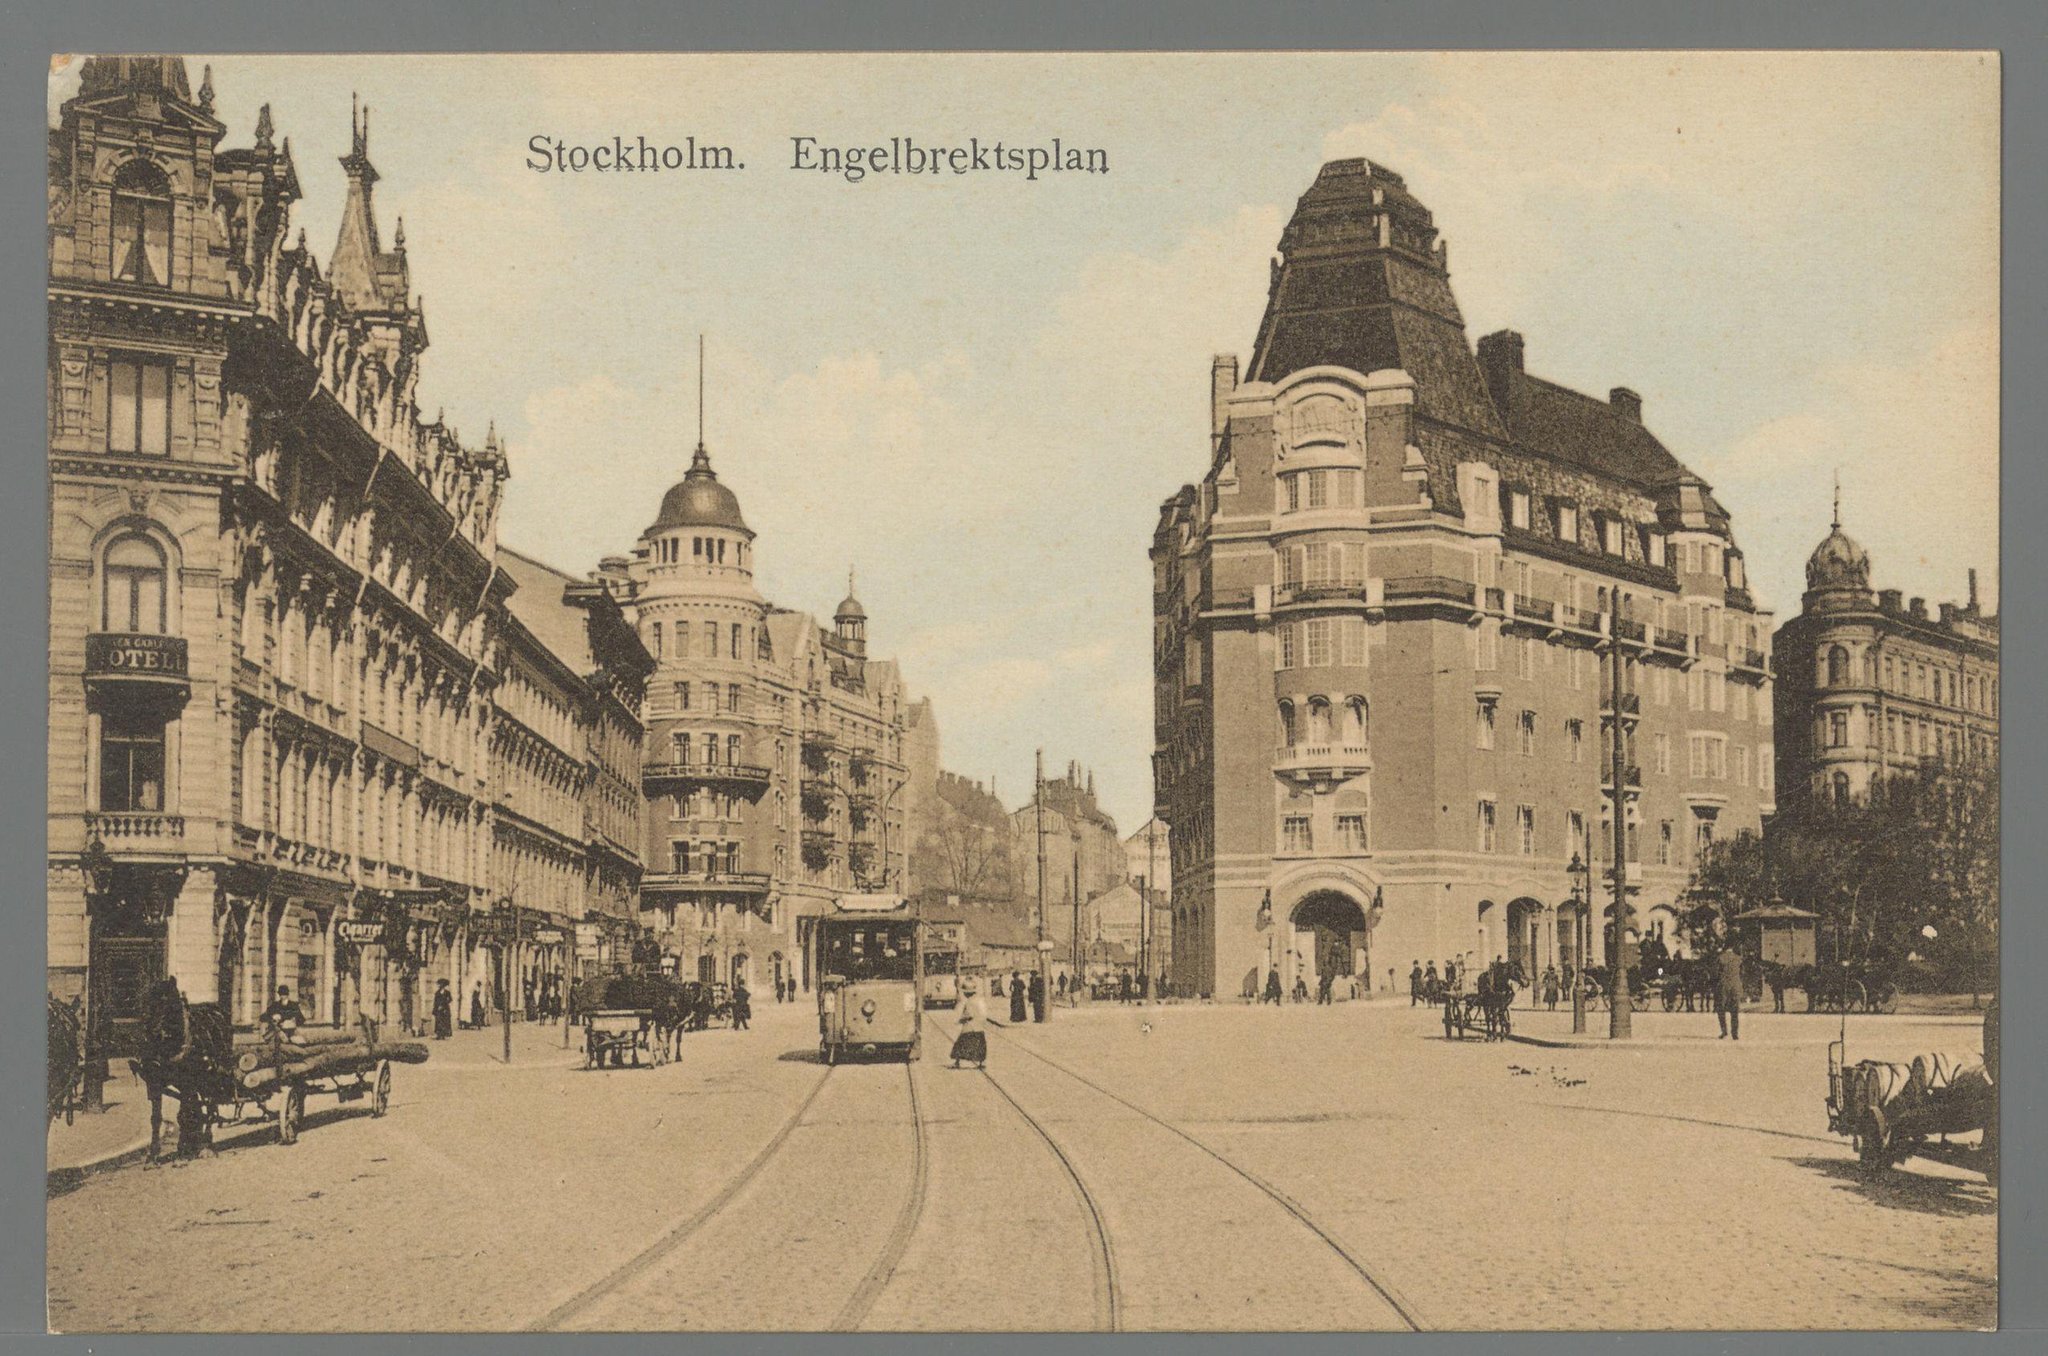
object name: photomechanical print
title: Stockholm. Engelbrektsplan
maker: Anonymous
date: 1905-1930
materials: cardboard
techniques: photograph, lithograph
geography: stockholm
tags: square, place, circus, etc.